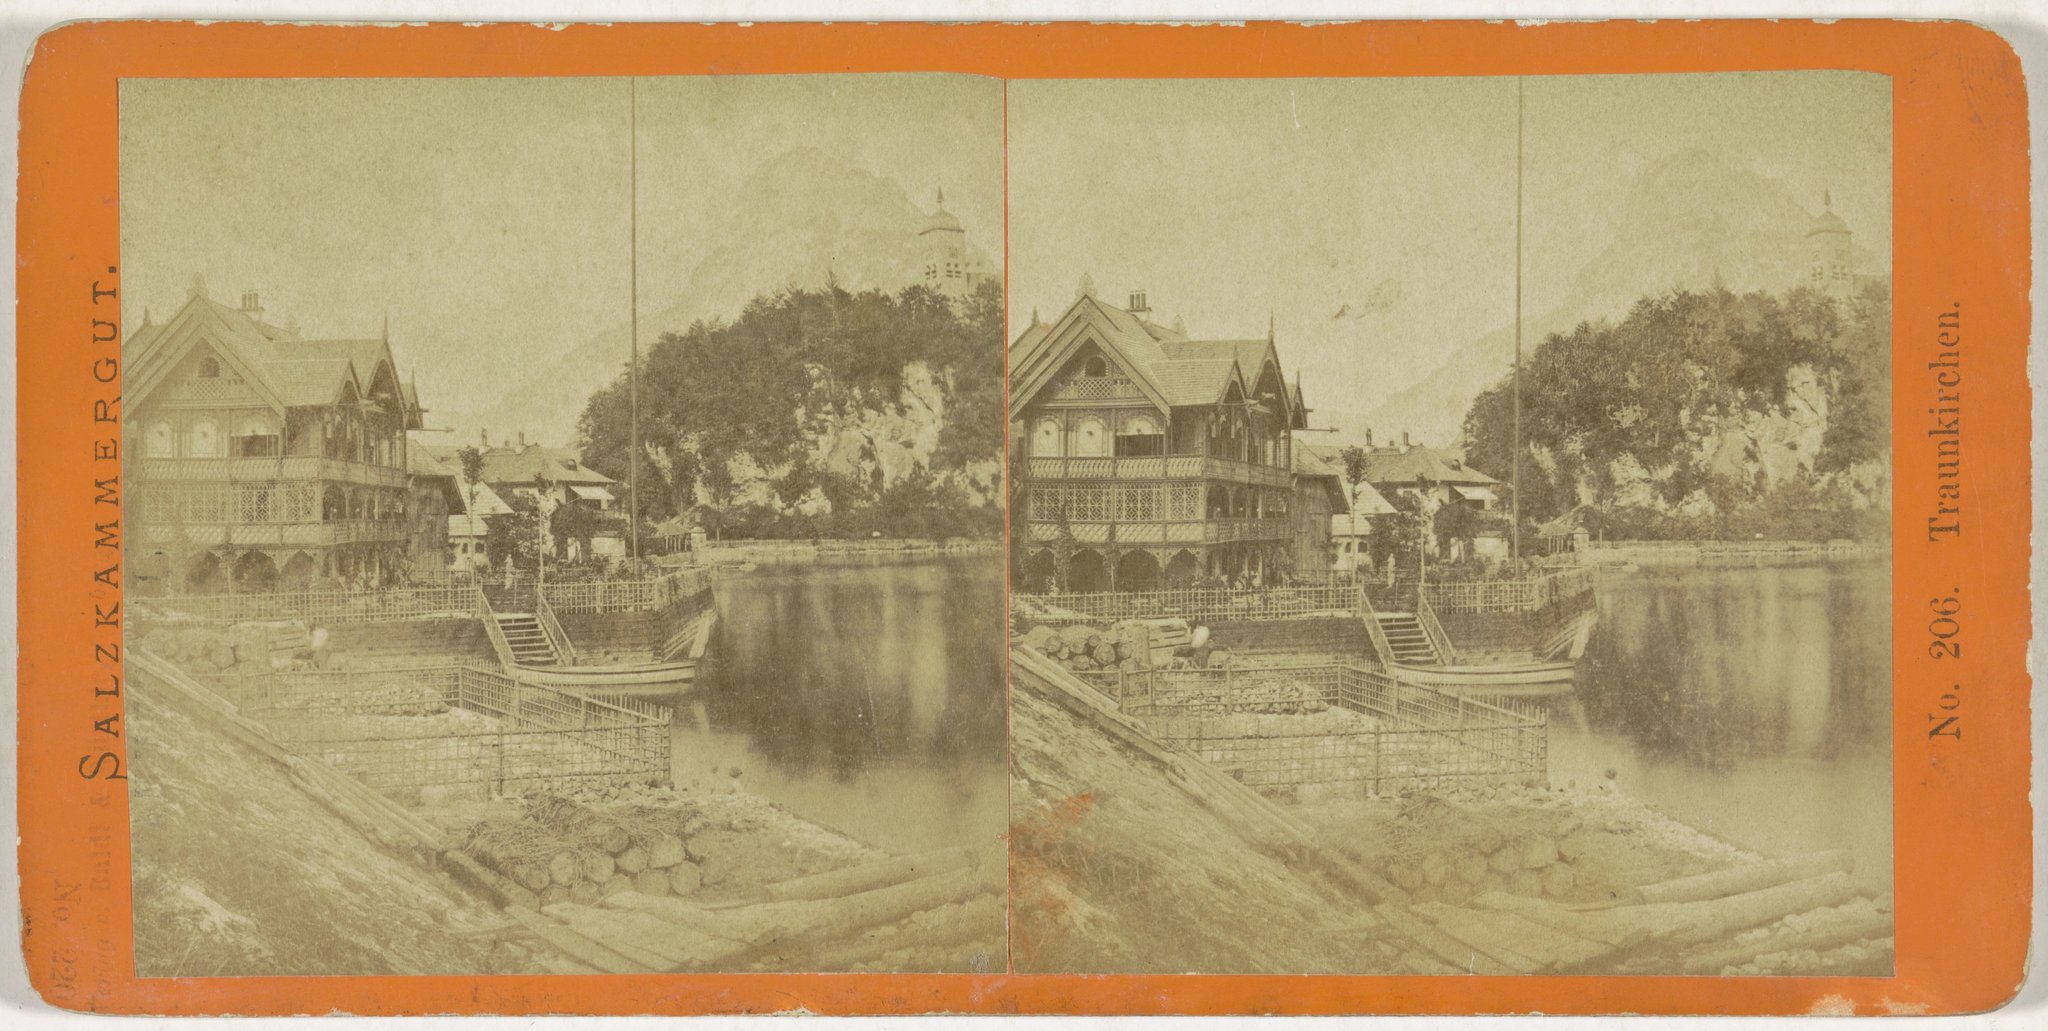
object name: stereograph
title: Traunkirchen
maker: Anonymous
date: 1862-1880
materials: cardboard, paper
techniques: albumen print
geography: salzburg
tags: industries ~ wood, lake, pavement, terrace in front of inn or restaurant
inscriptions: number: ‘No. 206’, number: ‘No. 220’